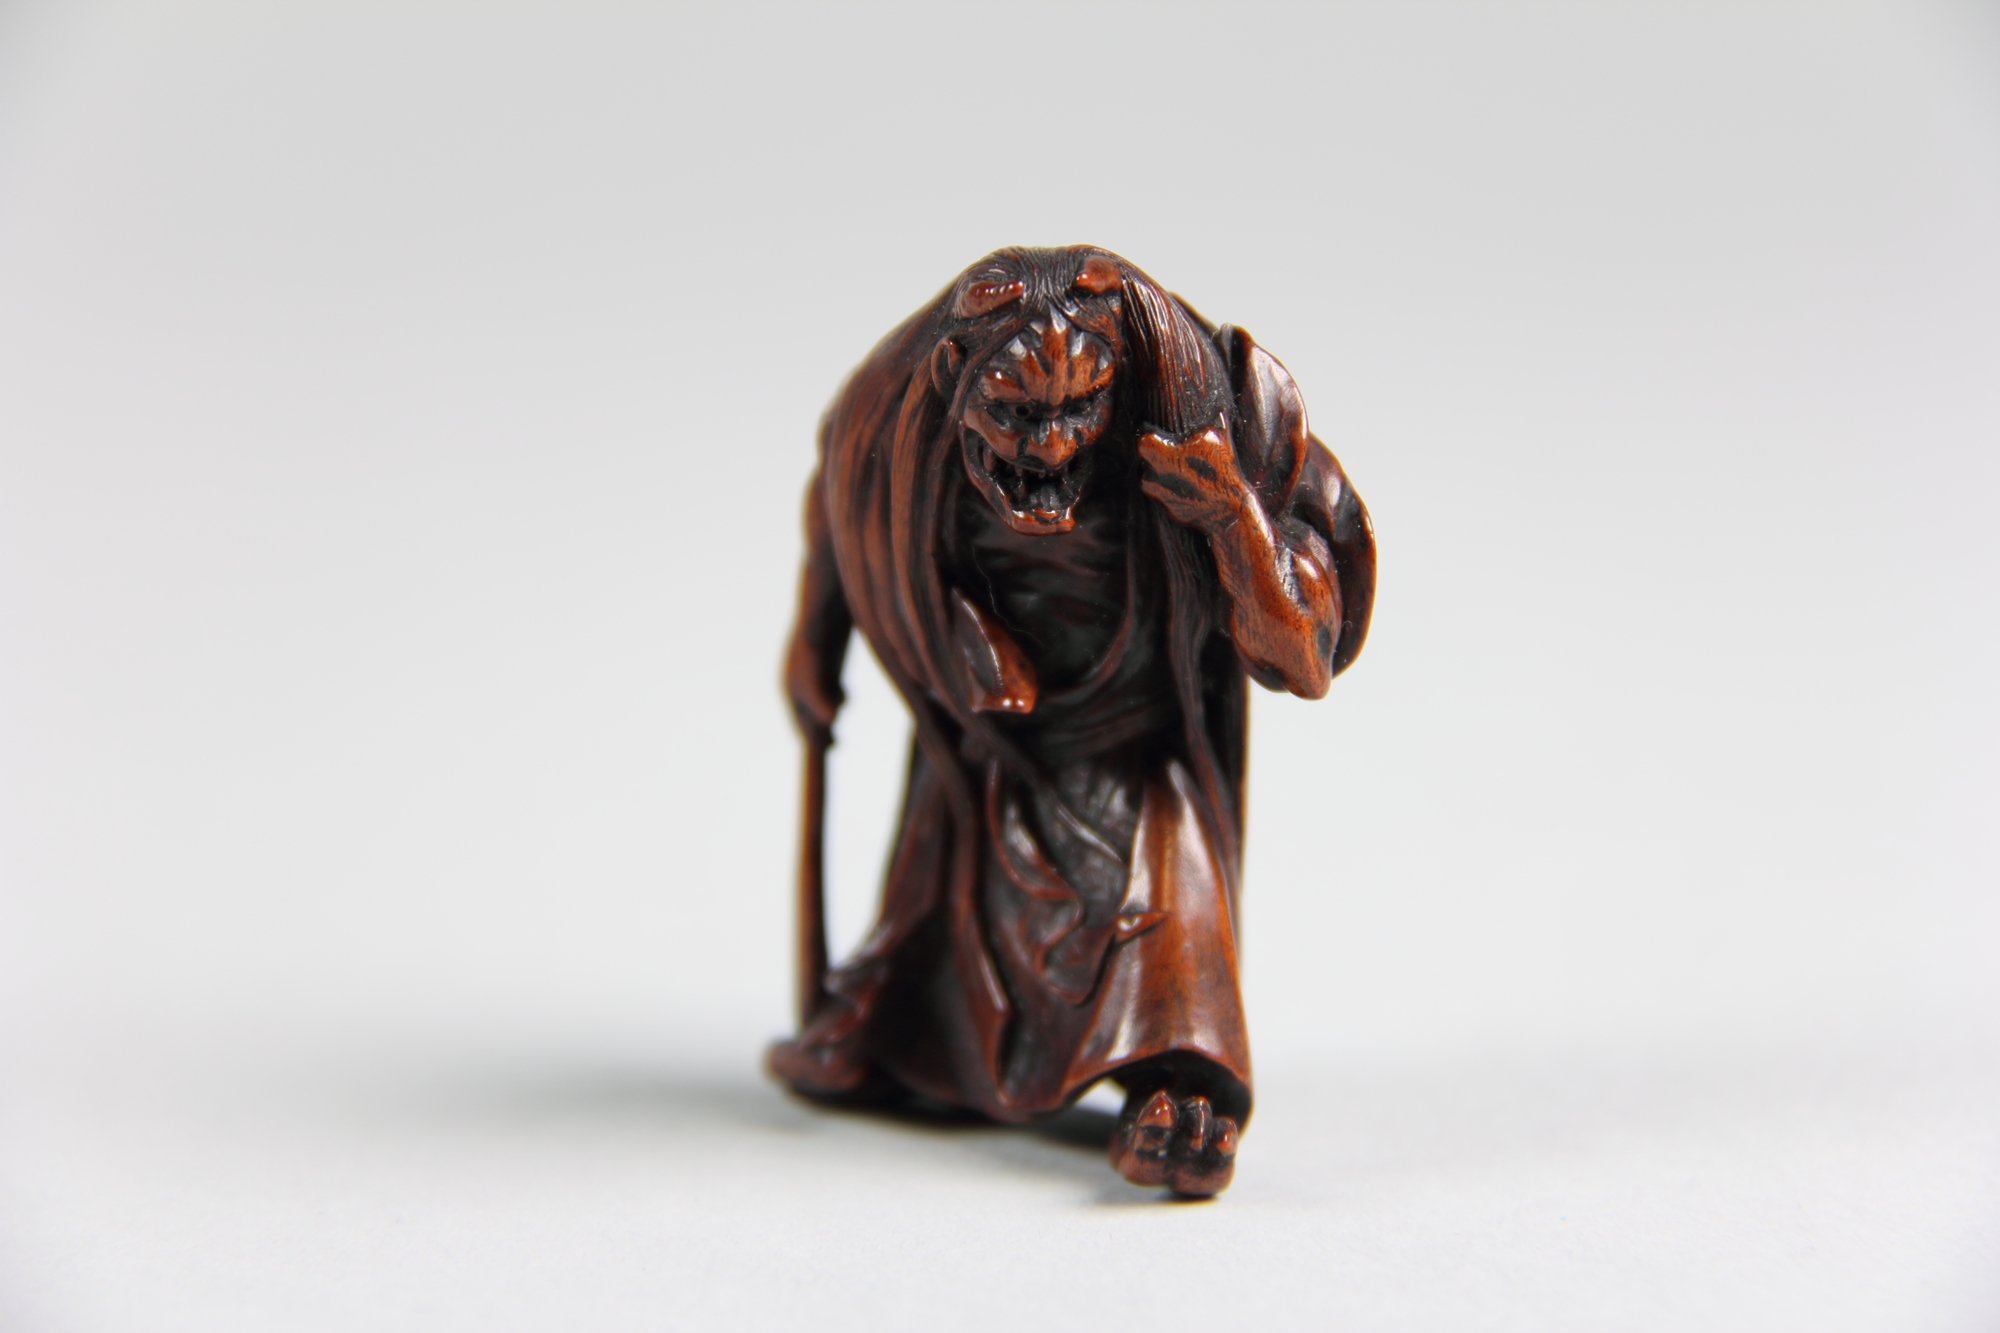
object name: netsuke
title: Netsuke of Demon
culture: japanese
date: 1701-1800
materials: wood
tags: demons